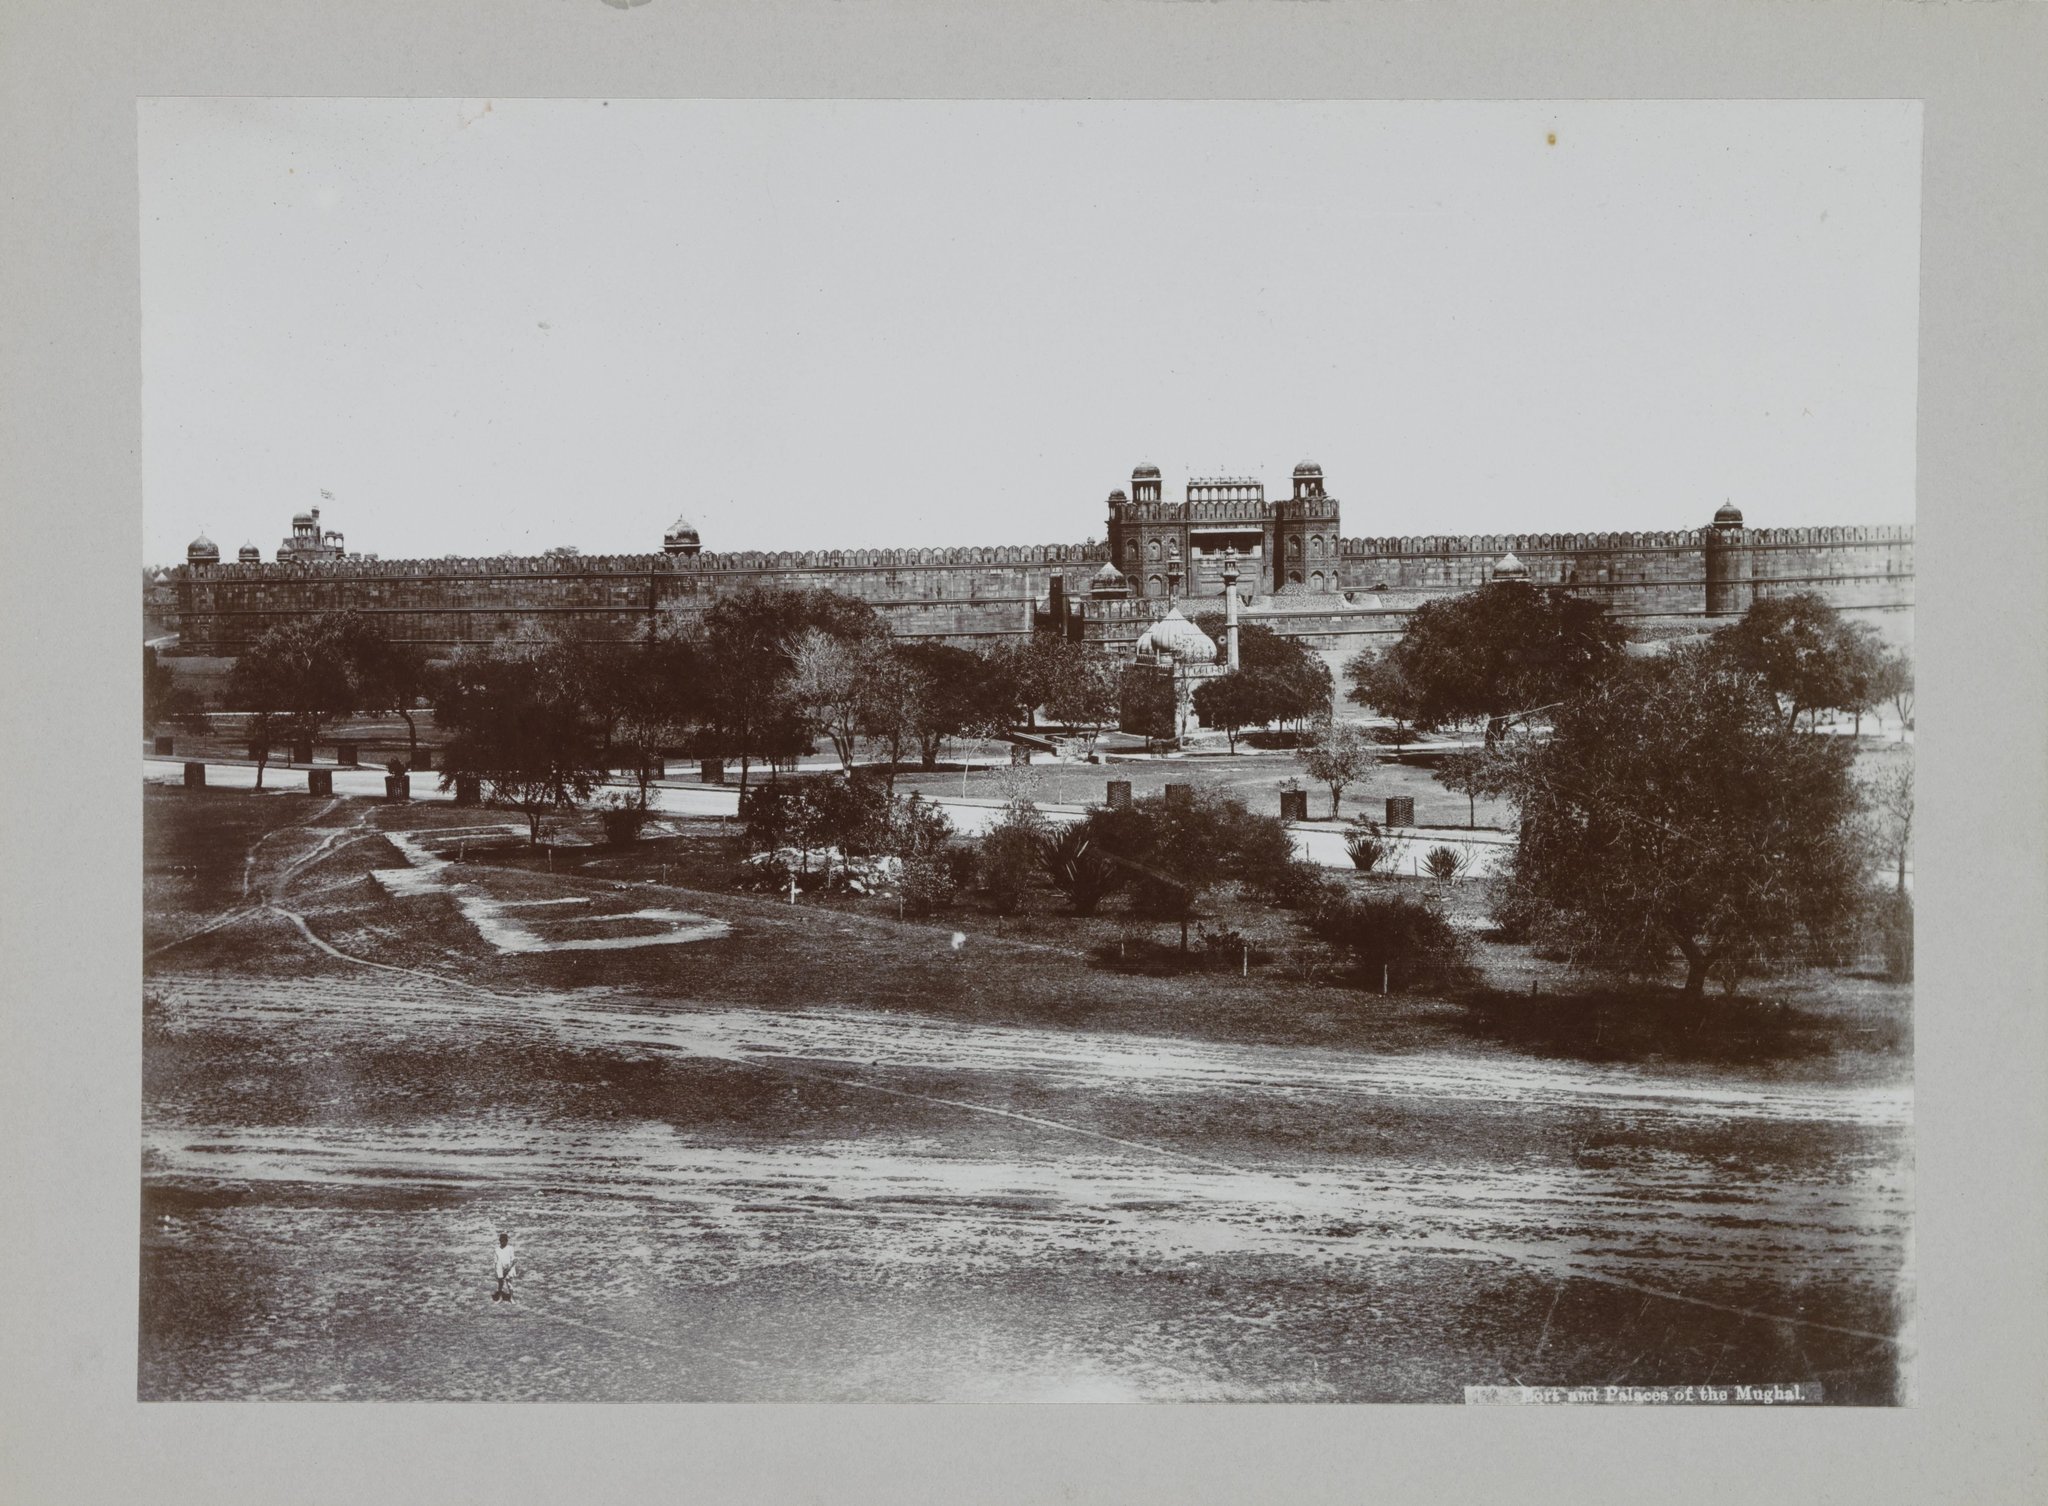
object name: photograph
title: Agra Fort, Uttar Pradesh, India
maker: Anonymous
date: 1895-1915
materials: cardboard, paper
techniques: gelatin silver print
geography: agra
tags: agra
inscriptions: annotation: ‘59. Fort van Agra.’, title: ‘Fort and Palaces of the Mughal.’